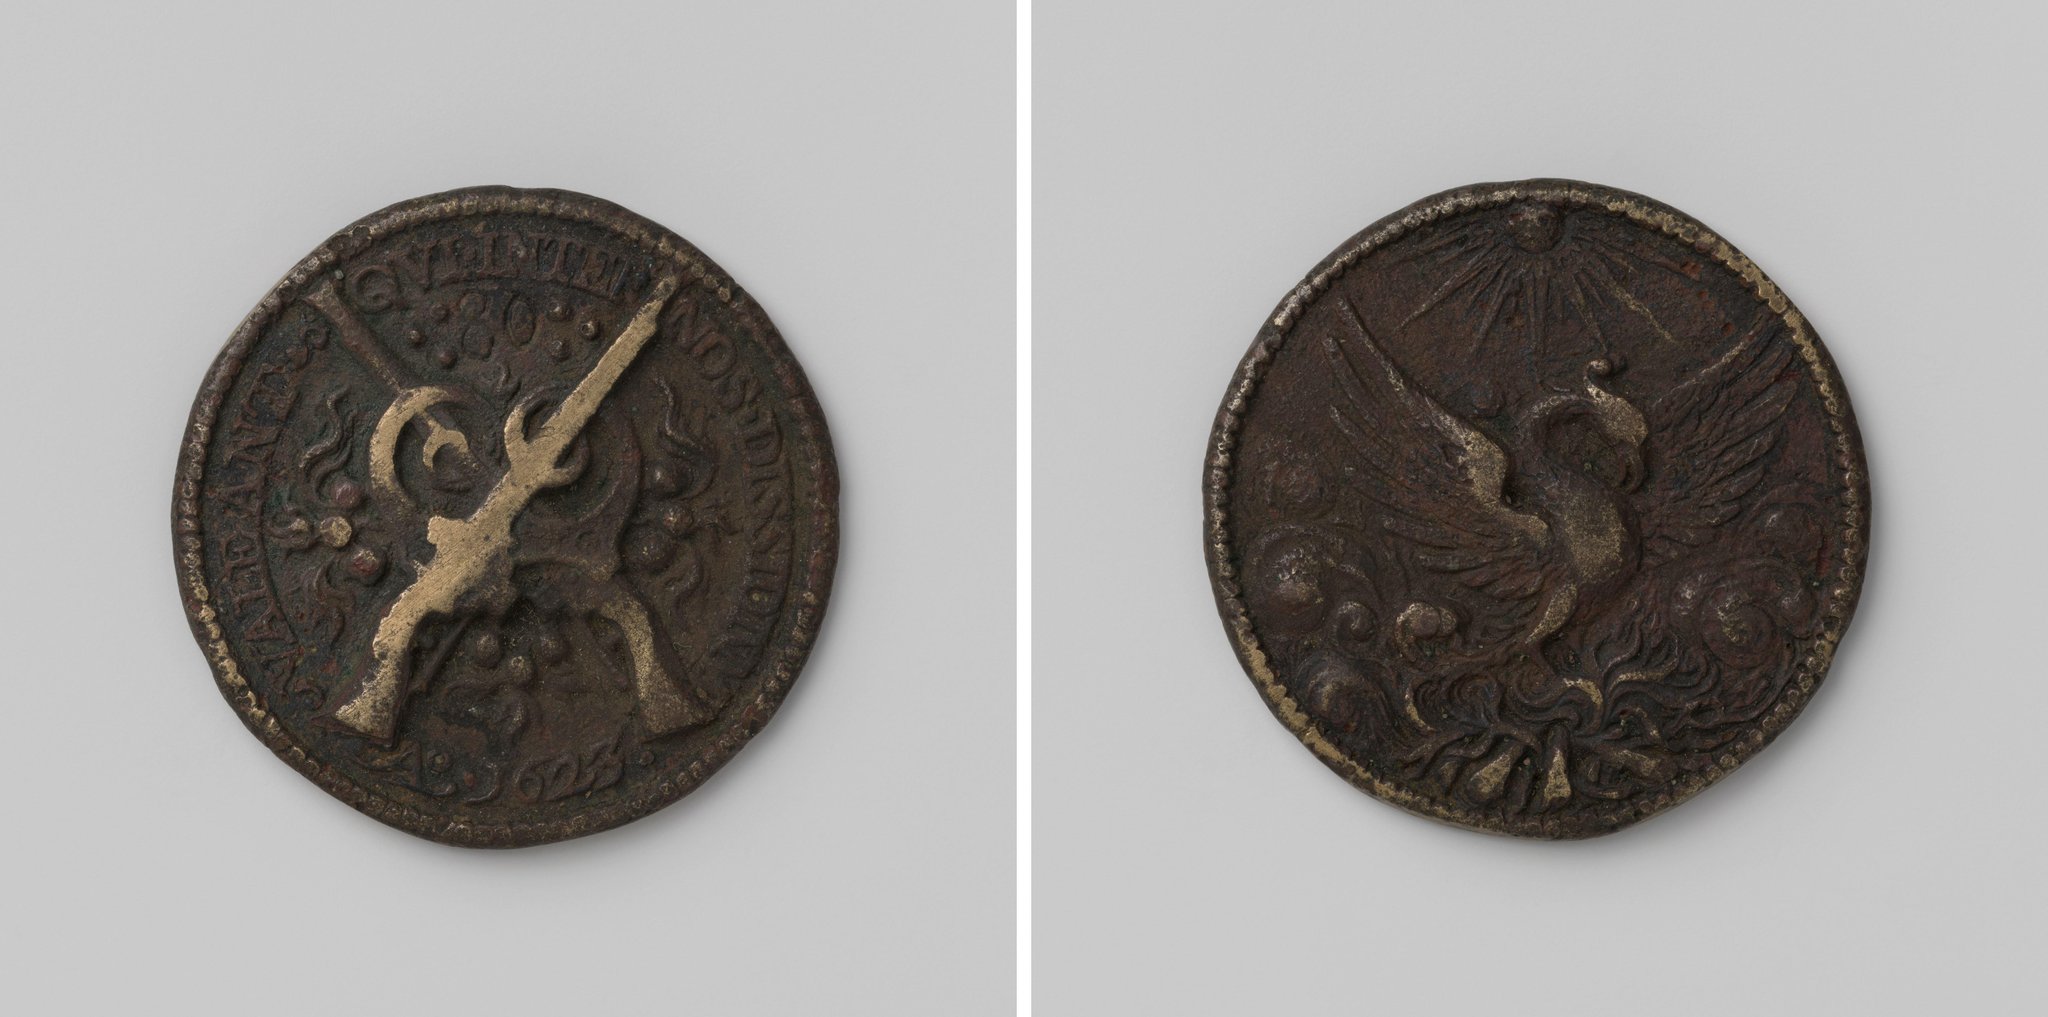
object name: marksman medal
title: Confrerie van de Edele Busse te Middelburg, schutterspenning met no. 80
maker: johannes looff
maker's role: die cutter, draughtsman, print maker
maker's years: -1651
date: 1623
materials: brass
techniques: casting, engraving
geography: middelburg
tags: middelburg